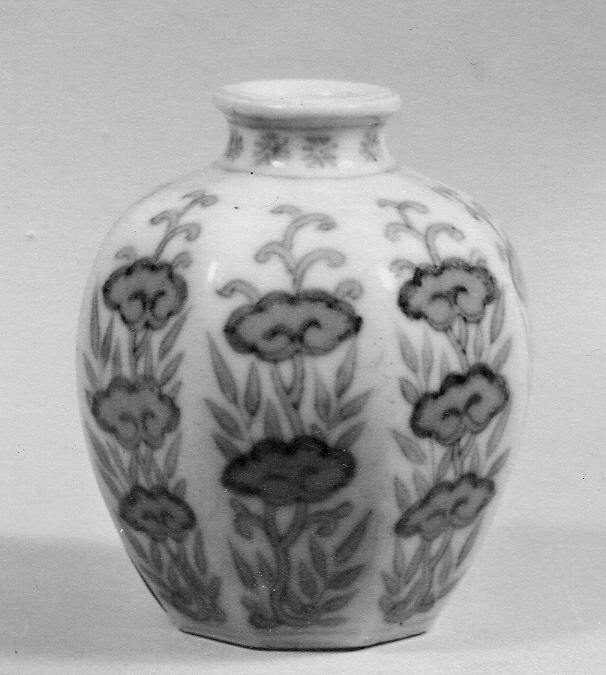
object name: snuff bottle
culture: chinese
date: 1736-1795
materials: porcelain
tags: flowers